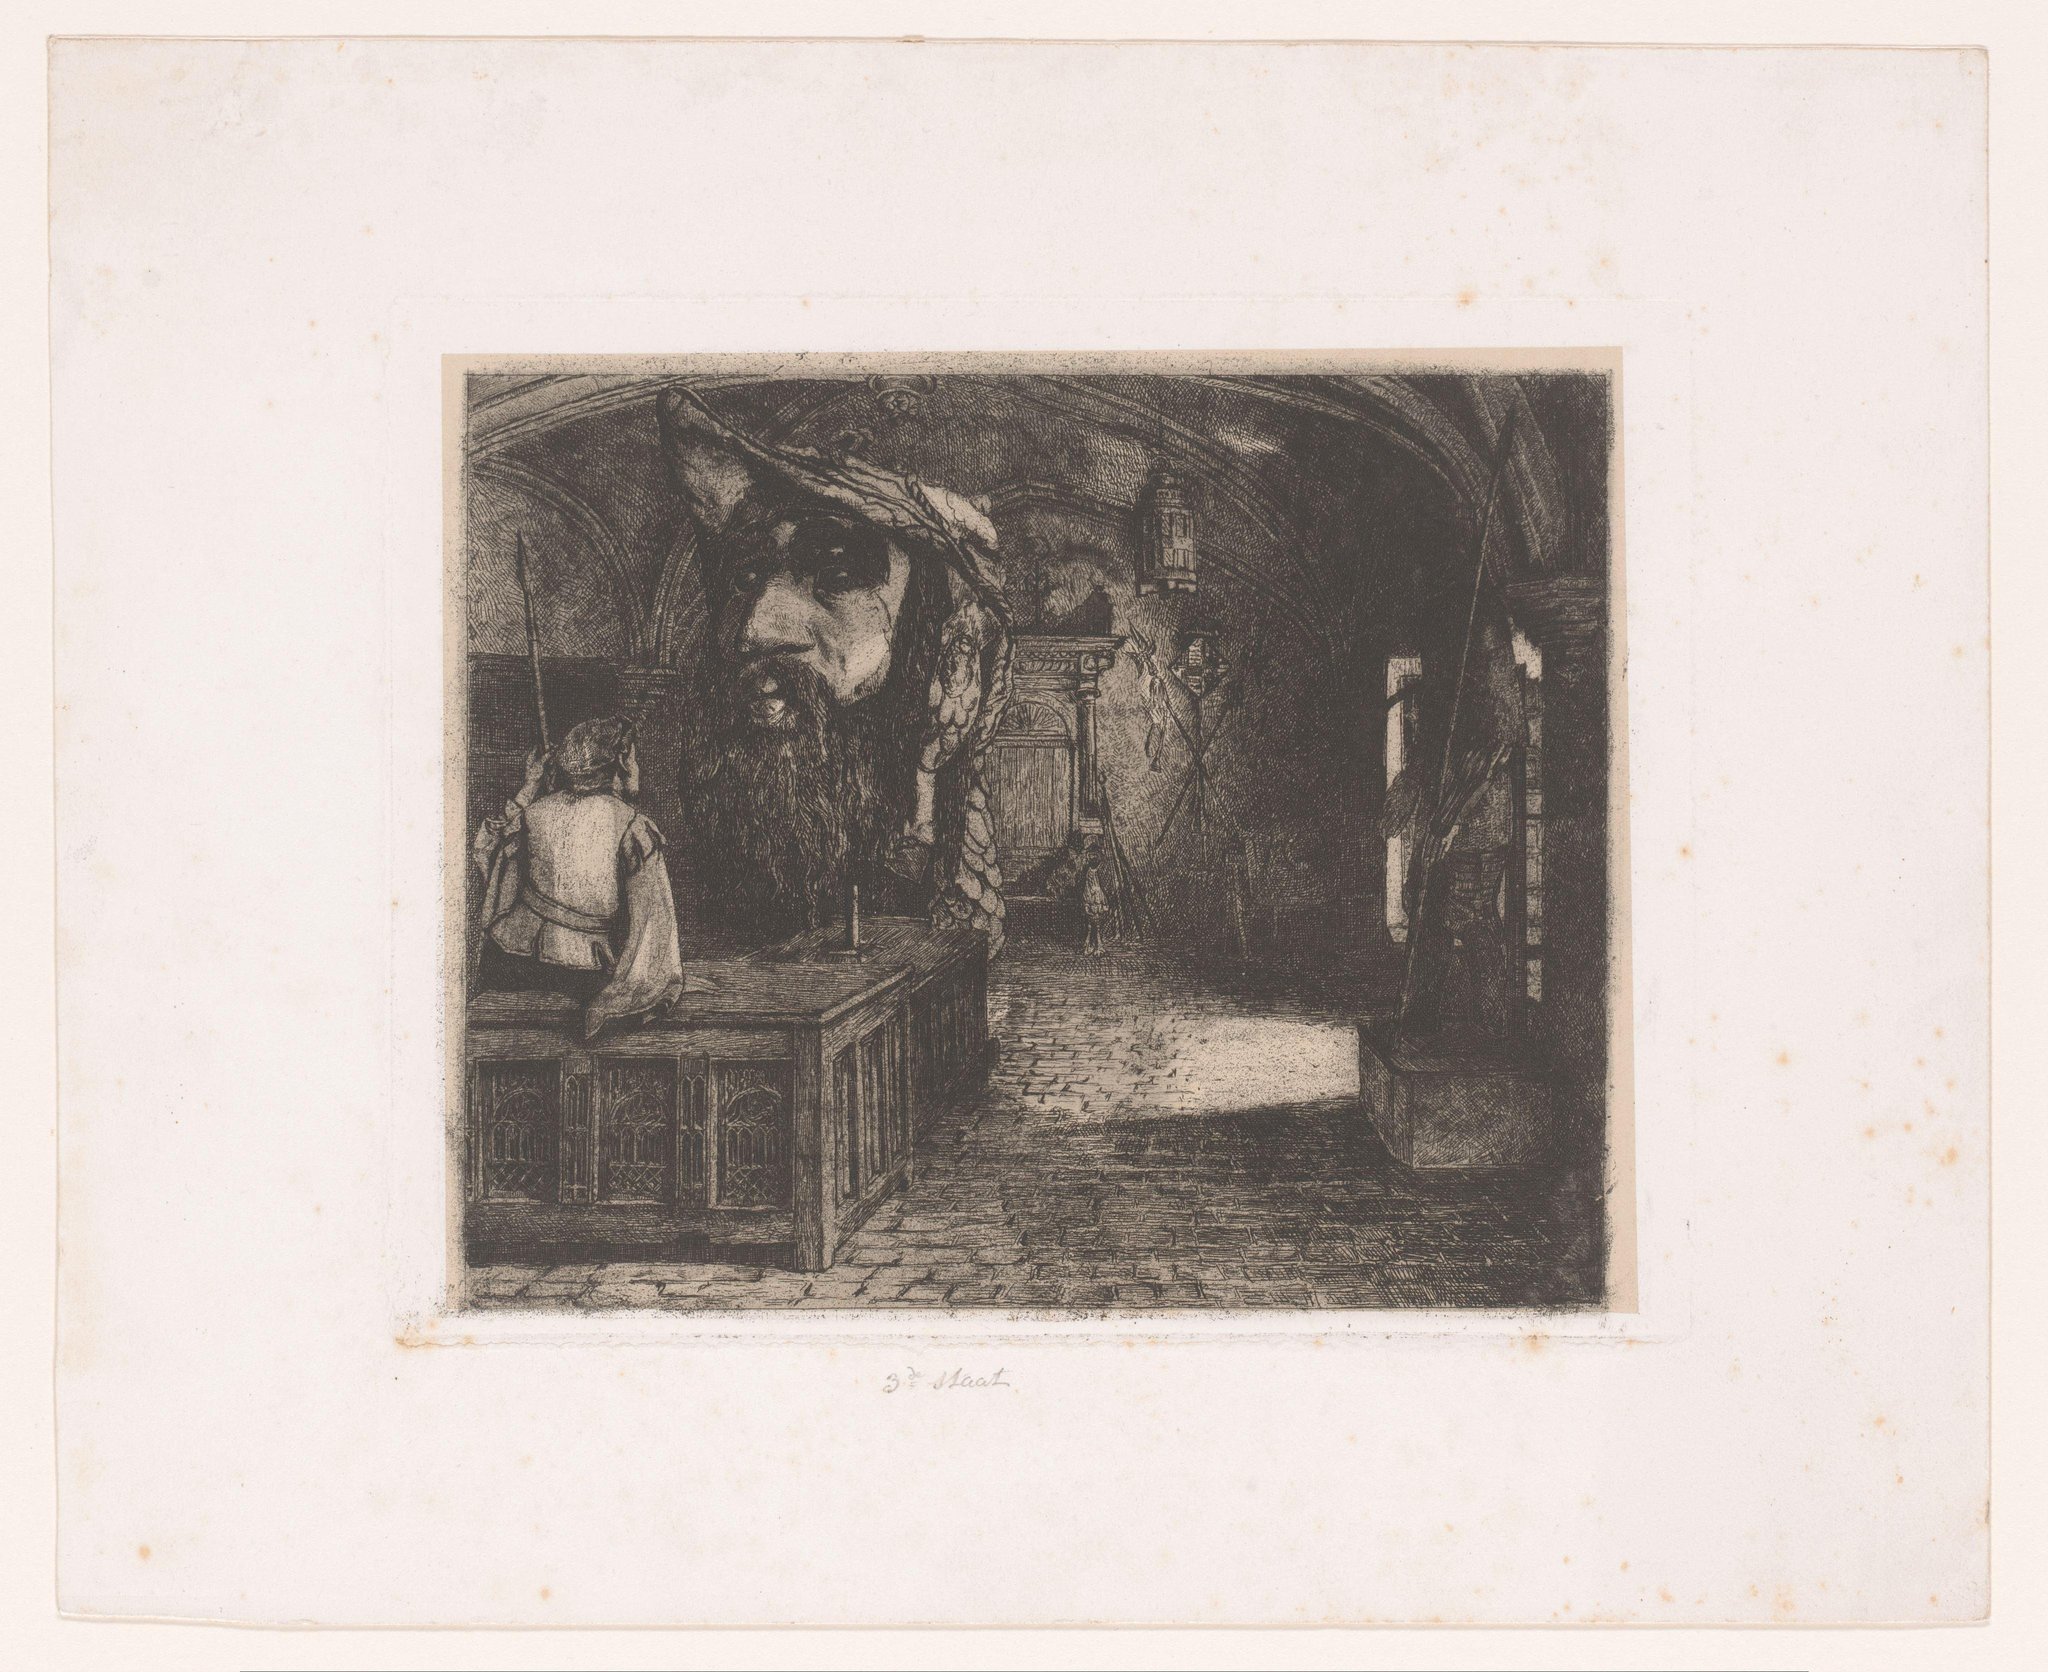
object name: print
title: Zaal van museum Het Steen in Antwerpen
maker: jean-baptiste anthony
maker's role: painter, print maker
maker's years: 1854-1930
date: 1864-1909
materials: paper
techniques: etching, intaglio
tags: armour, helved weapons, polearms (for striking, hacking, thrusting), permanent exhibition, museum, antwerp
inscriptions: collector's mark: Lugt 2228